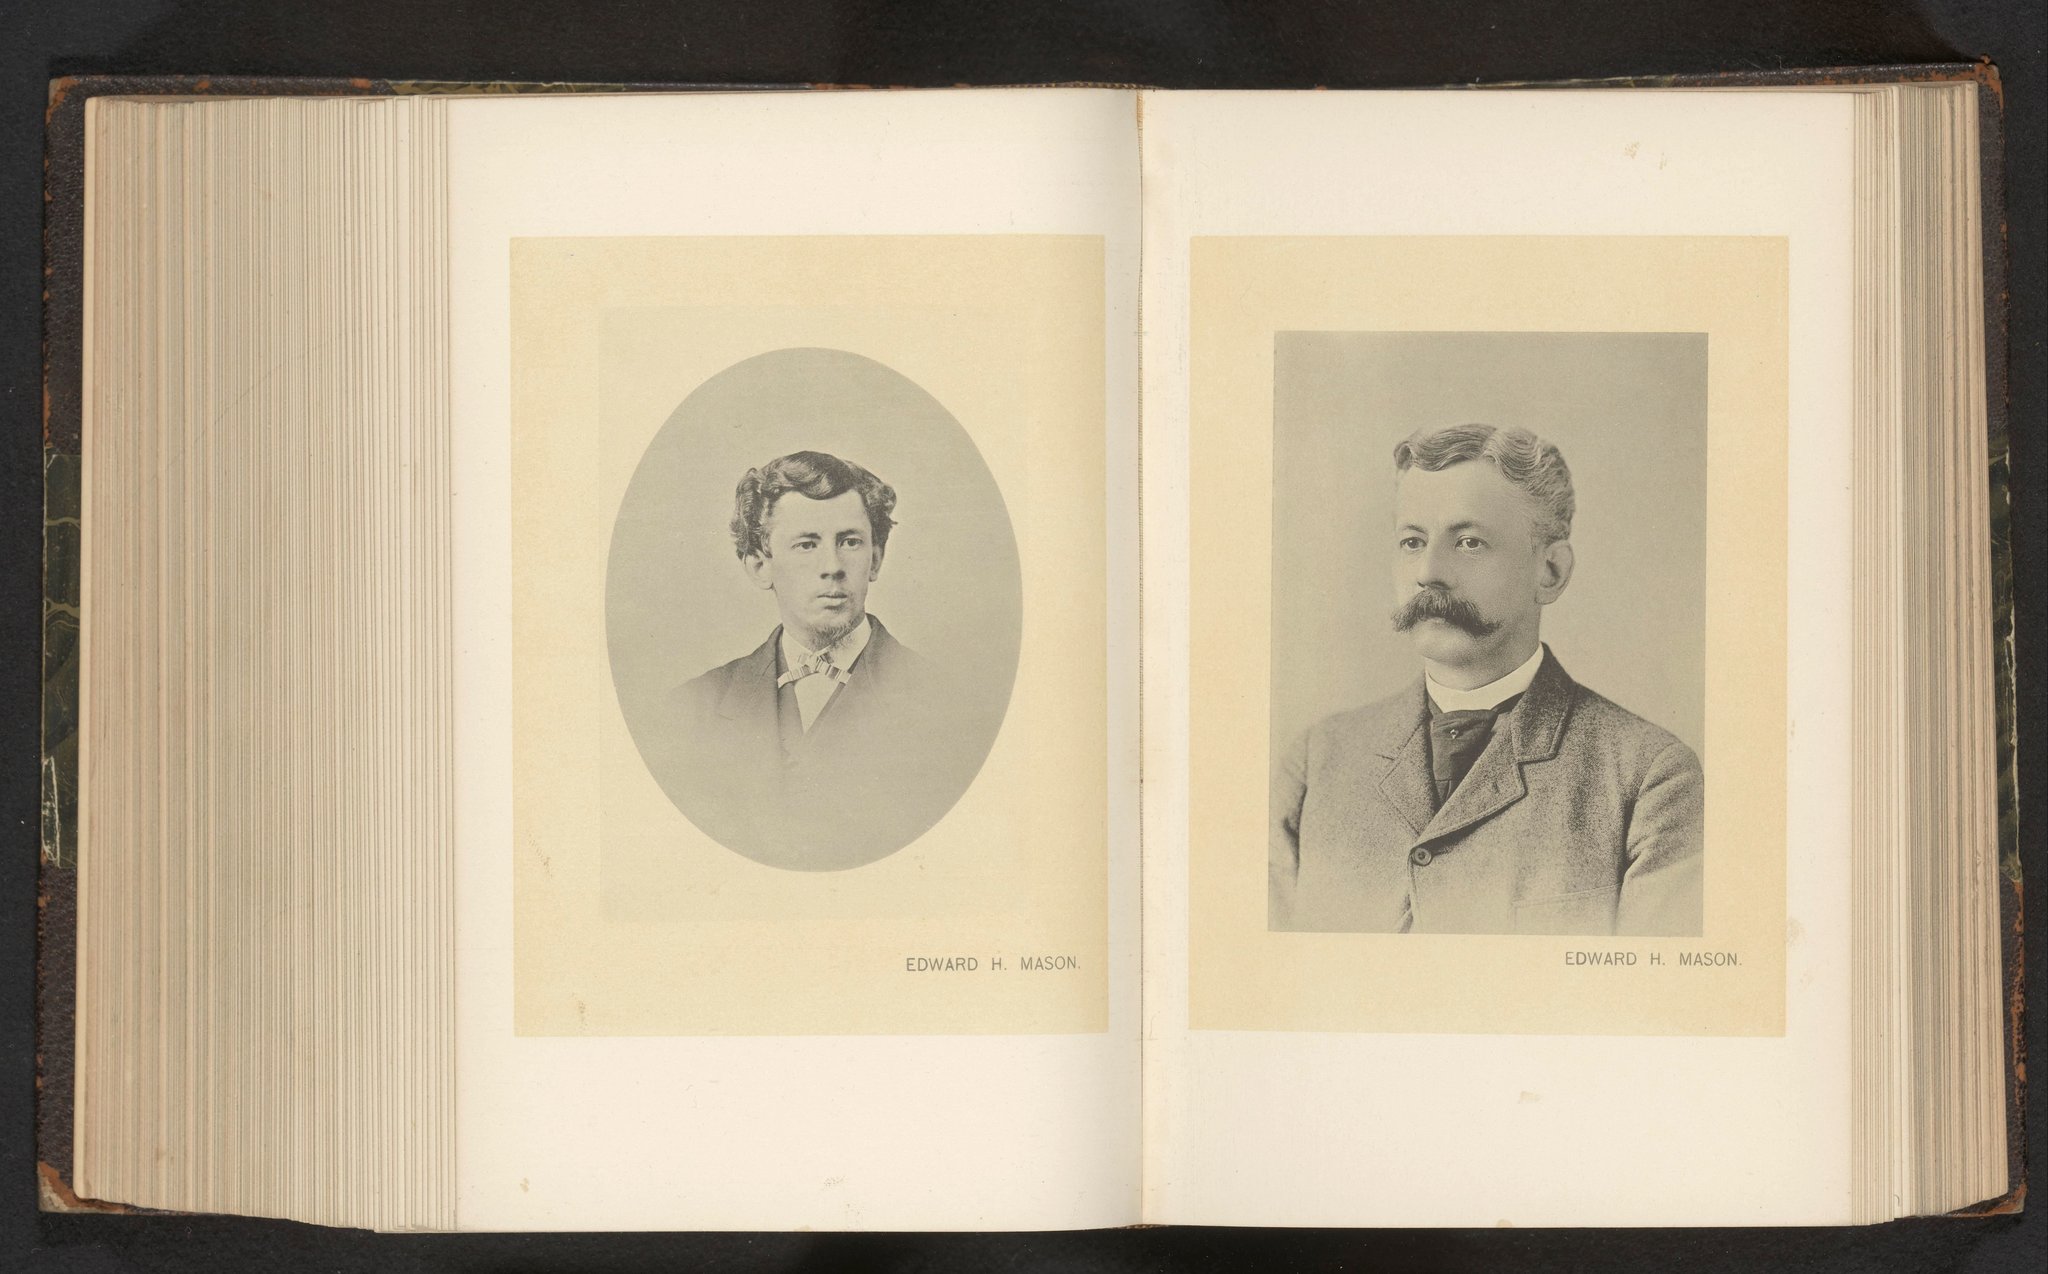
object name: photomechanical print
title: Edward H. Mason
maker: Anonymous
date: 1889-1894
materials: paper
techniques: photoaquatint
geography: boston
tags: adult man